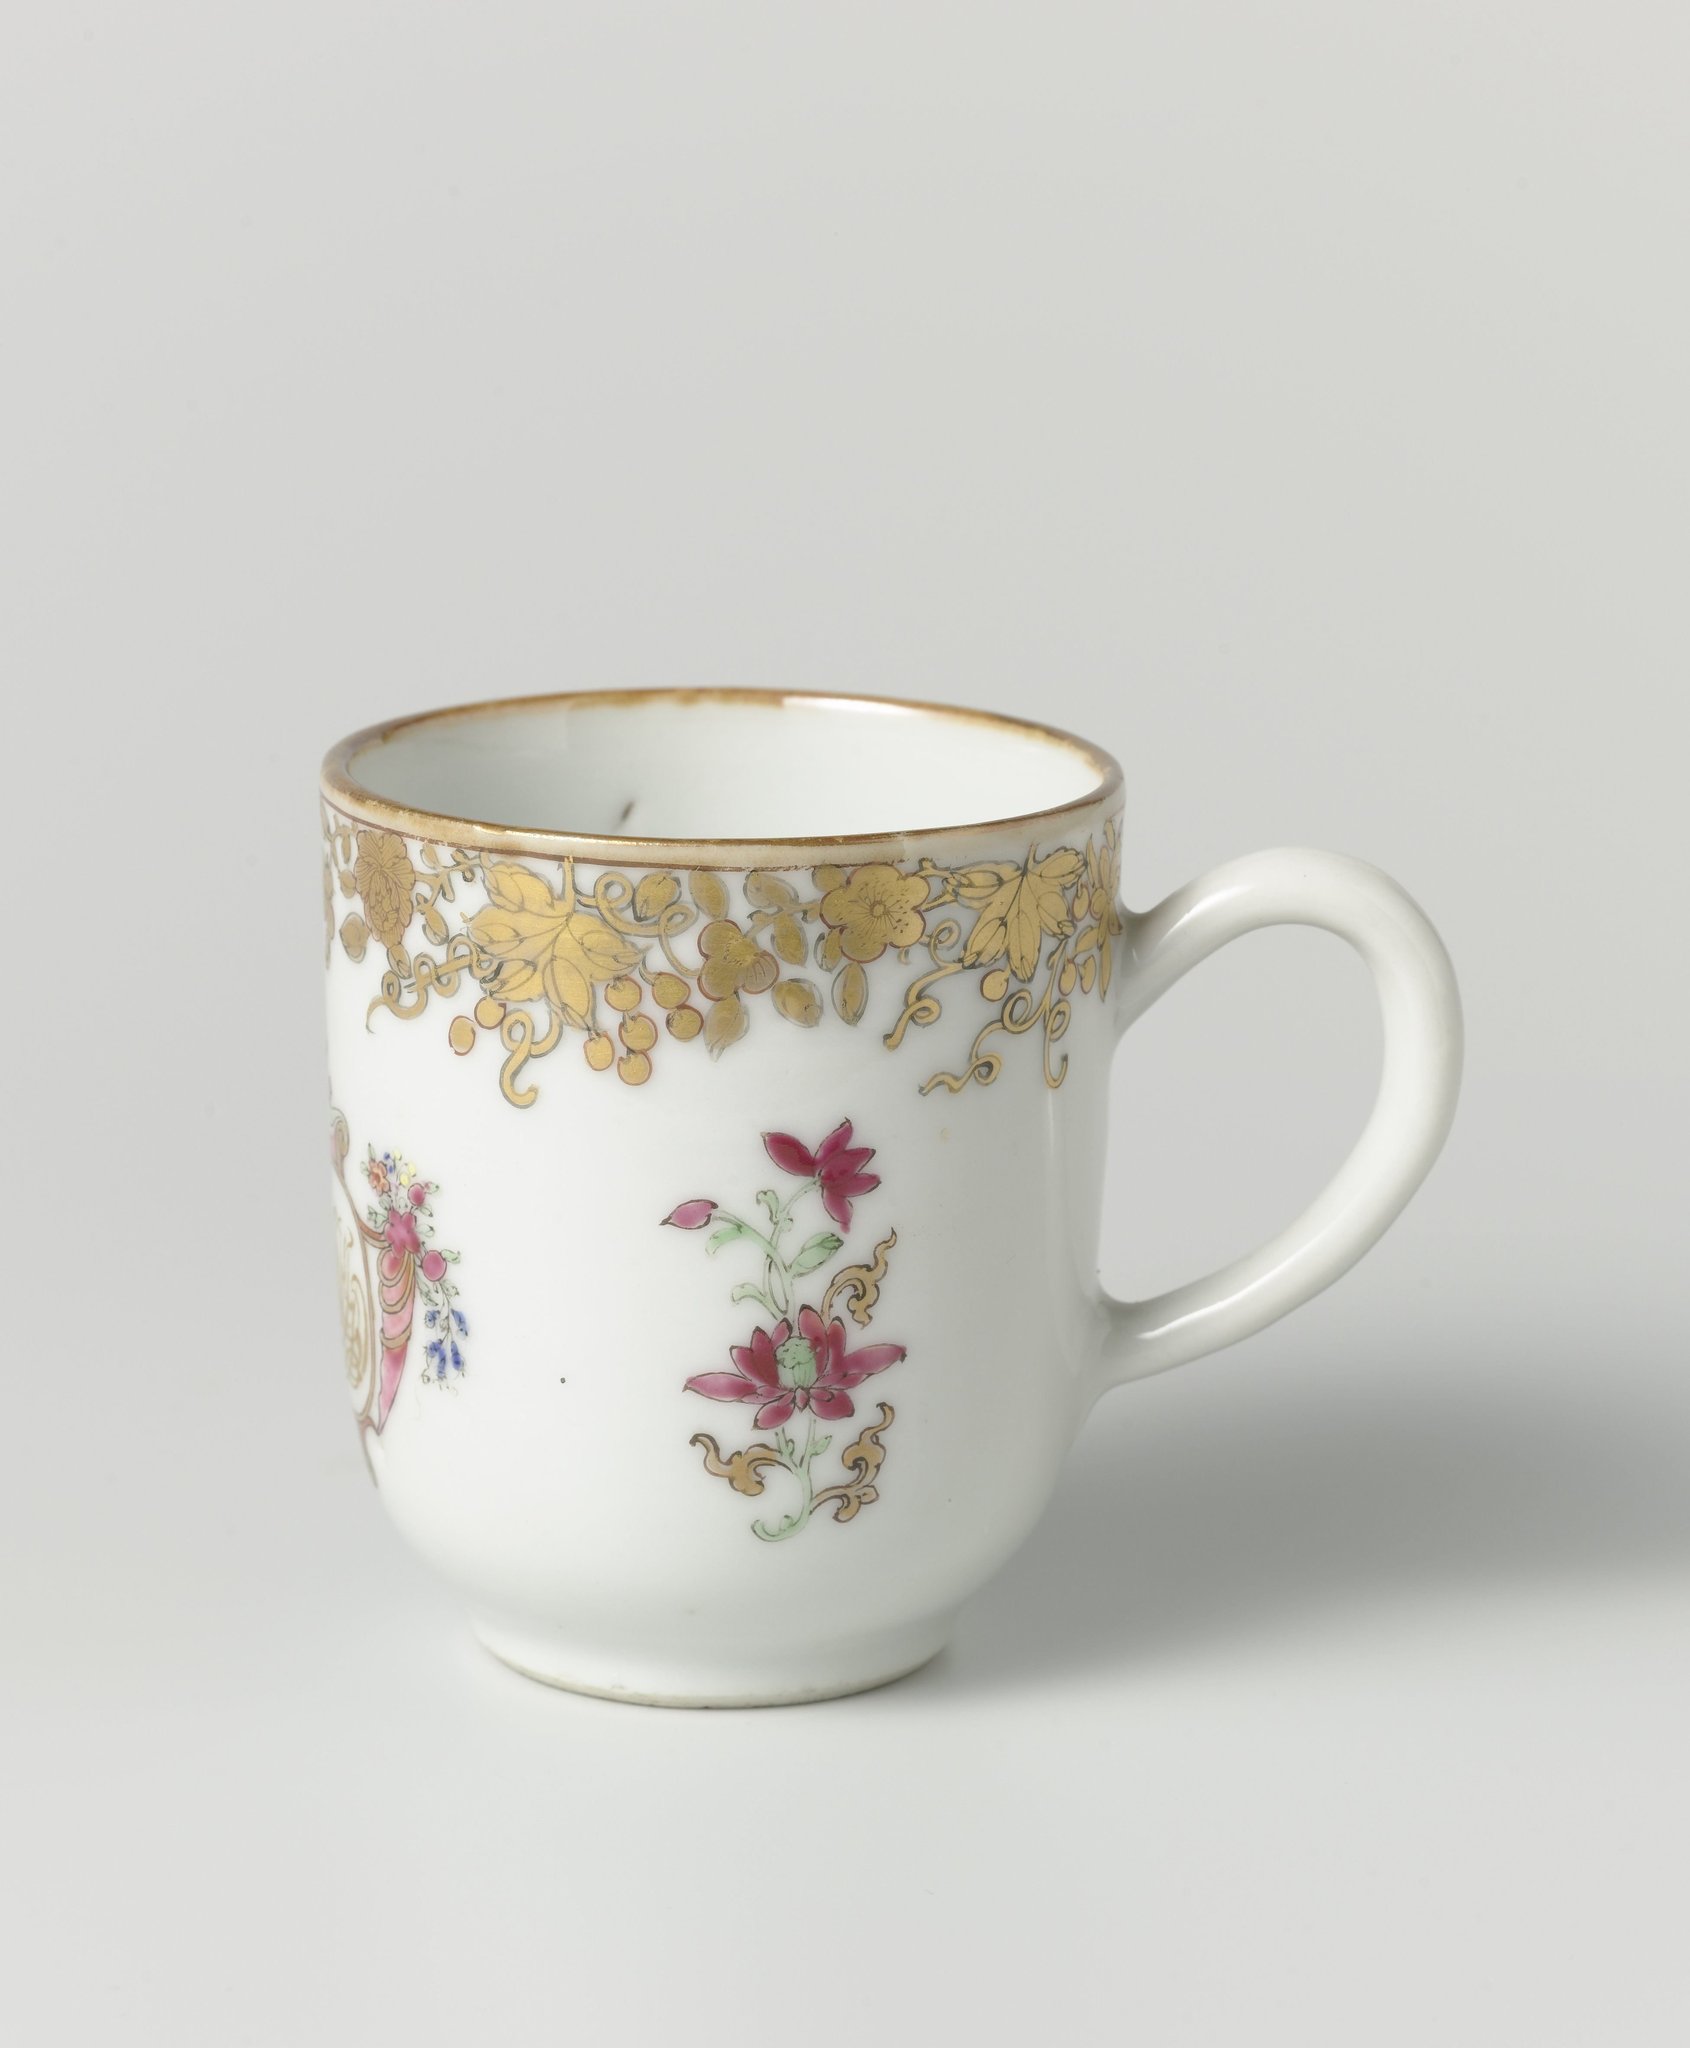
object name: oorkop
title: Cup with handle from the 'Swellengrebel service' with a double crowned monogram and a border with floral scrolls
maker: Anonymous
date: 1740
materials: glaze, gold, paint, porcelain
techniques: firing, gilding, turning, vitrification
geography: china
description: De monogrammen 'MVA' en 'CHTD' staan voor Maurits van Aerden (1694-1746) en Constantia Helena ten Damme (1694-1772), getrouwd in 1716. Het servies is waarschijnlijk besteld ter ere van hun vijfentwingtigjarig huwelijksjubileum in 1741. (Campen, Jan van & Hartkamp-Jonxis, Ebeltje, Aziatische weelde : VOC-kunst in het Rijksmuseum, Zutphen 2011, p. 78)